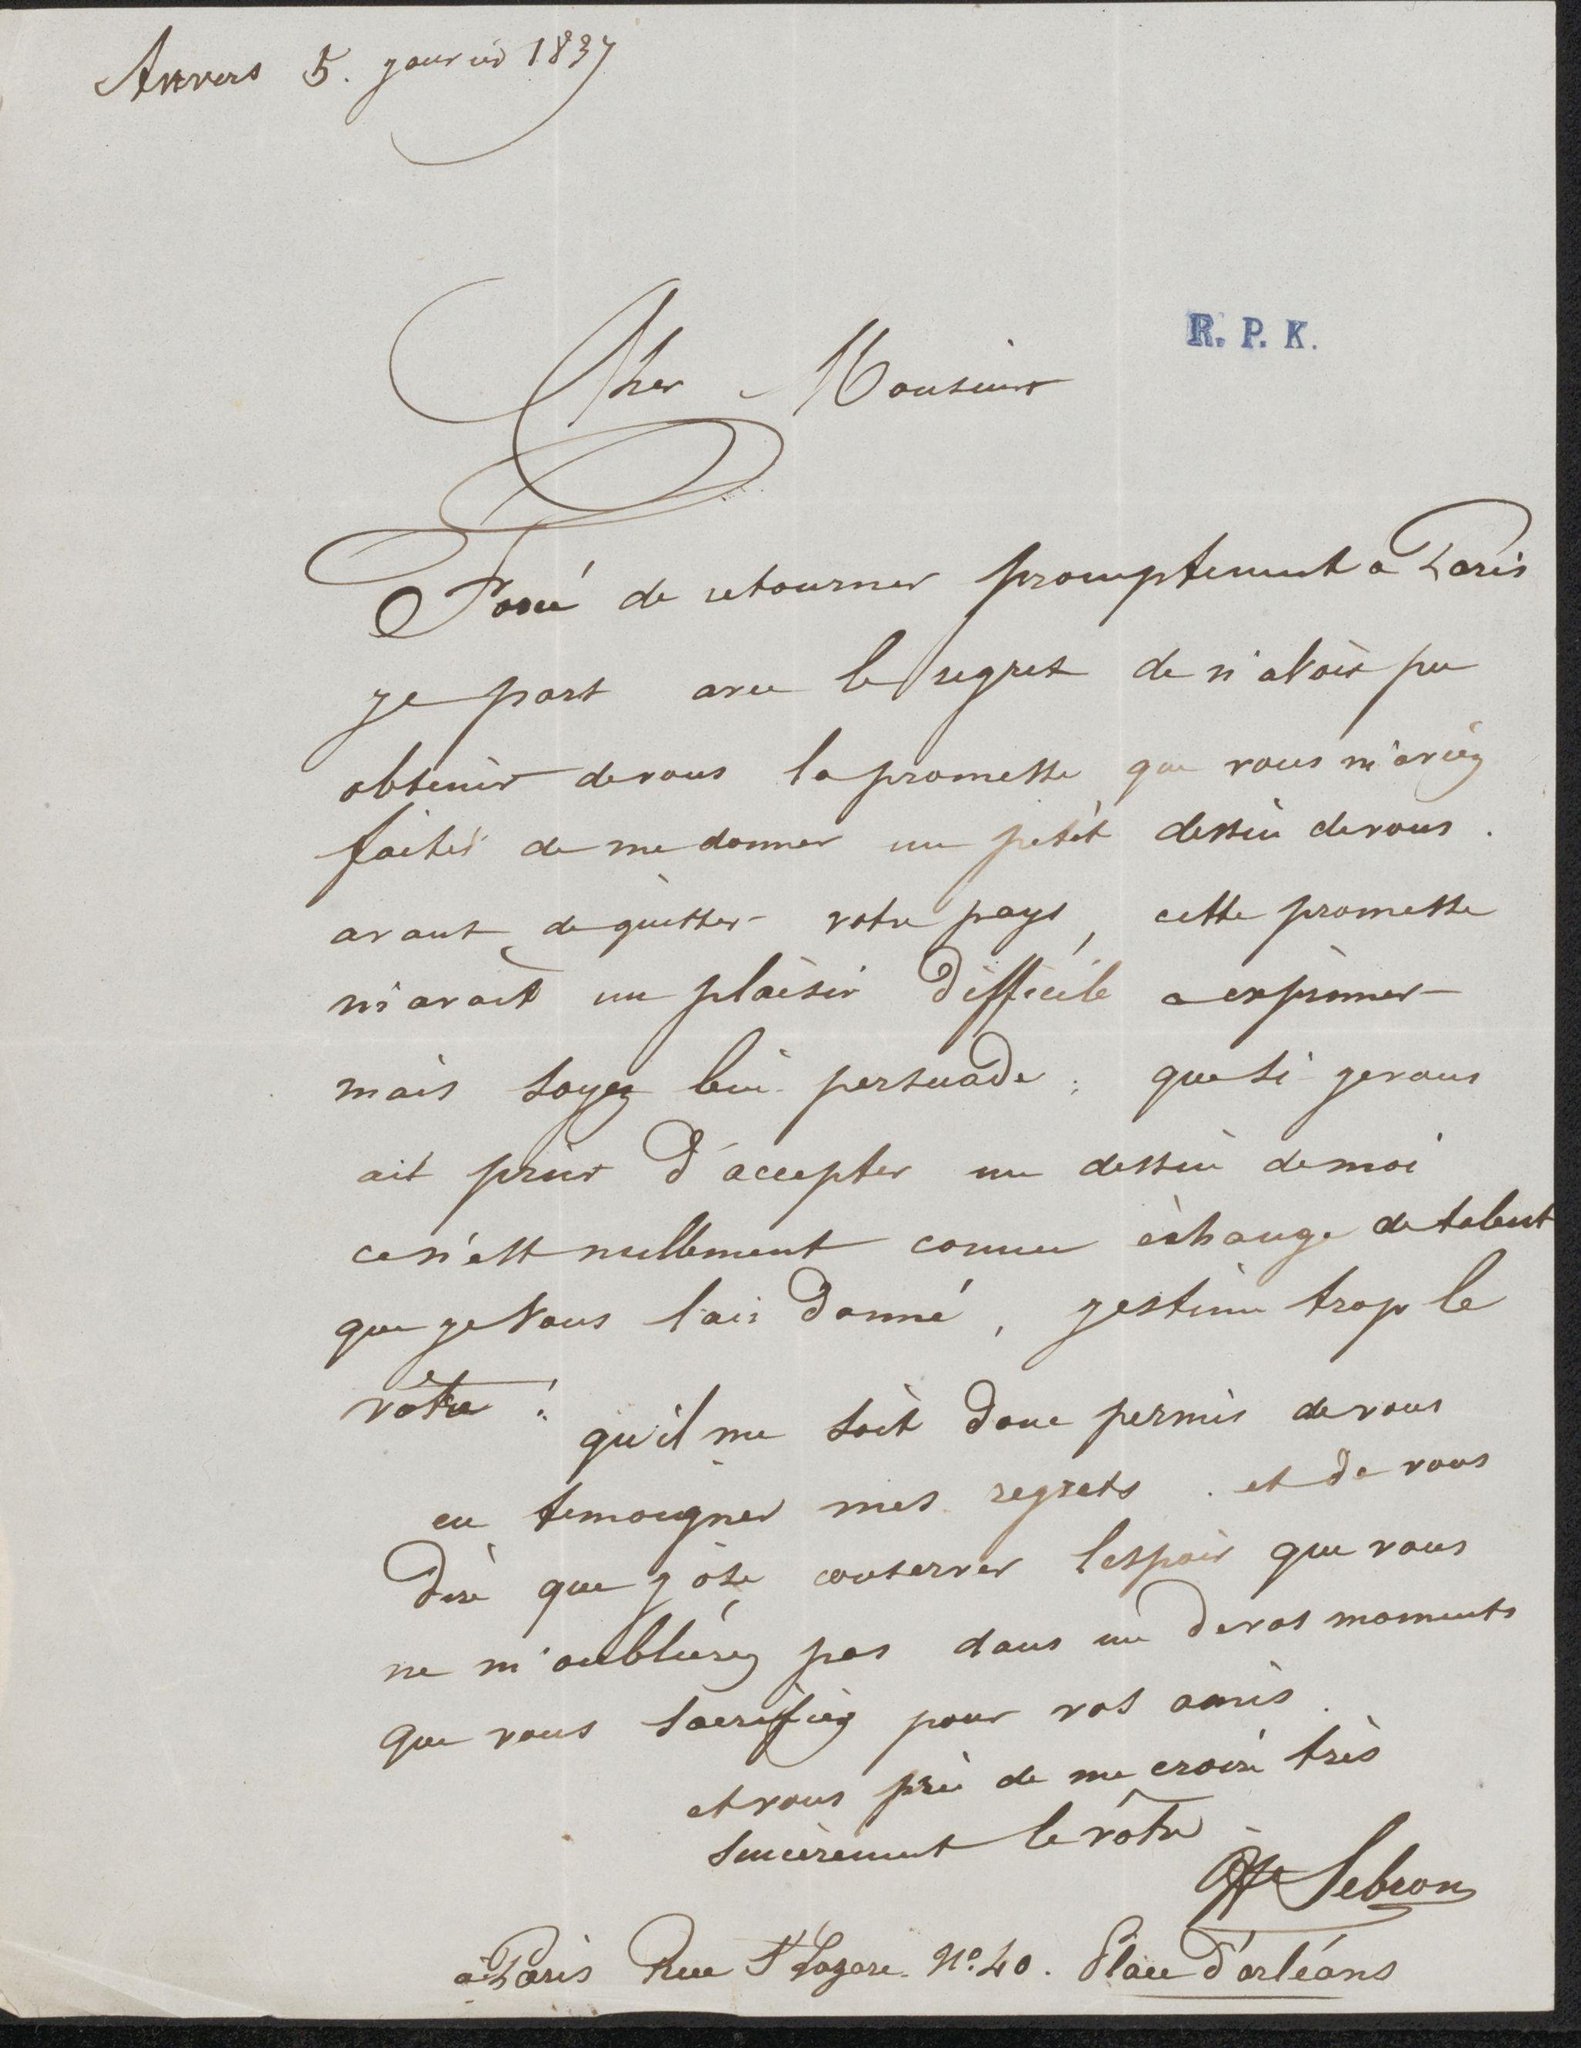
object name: letter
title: Brief aan anoniem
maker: hippolyte victor valentin sebron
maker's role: draughtsman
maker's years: 1801-1879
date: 1837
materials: ink, paper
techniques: pen, writing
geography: antwerp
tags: drawing, paris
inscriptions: collector's mark: Lugt 2233